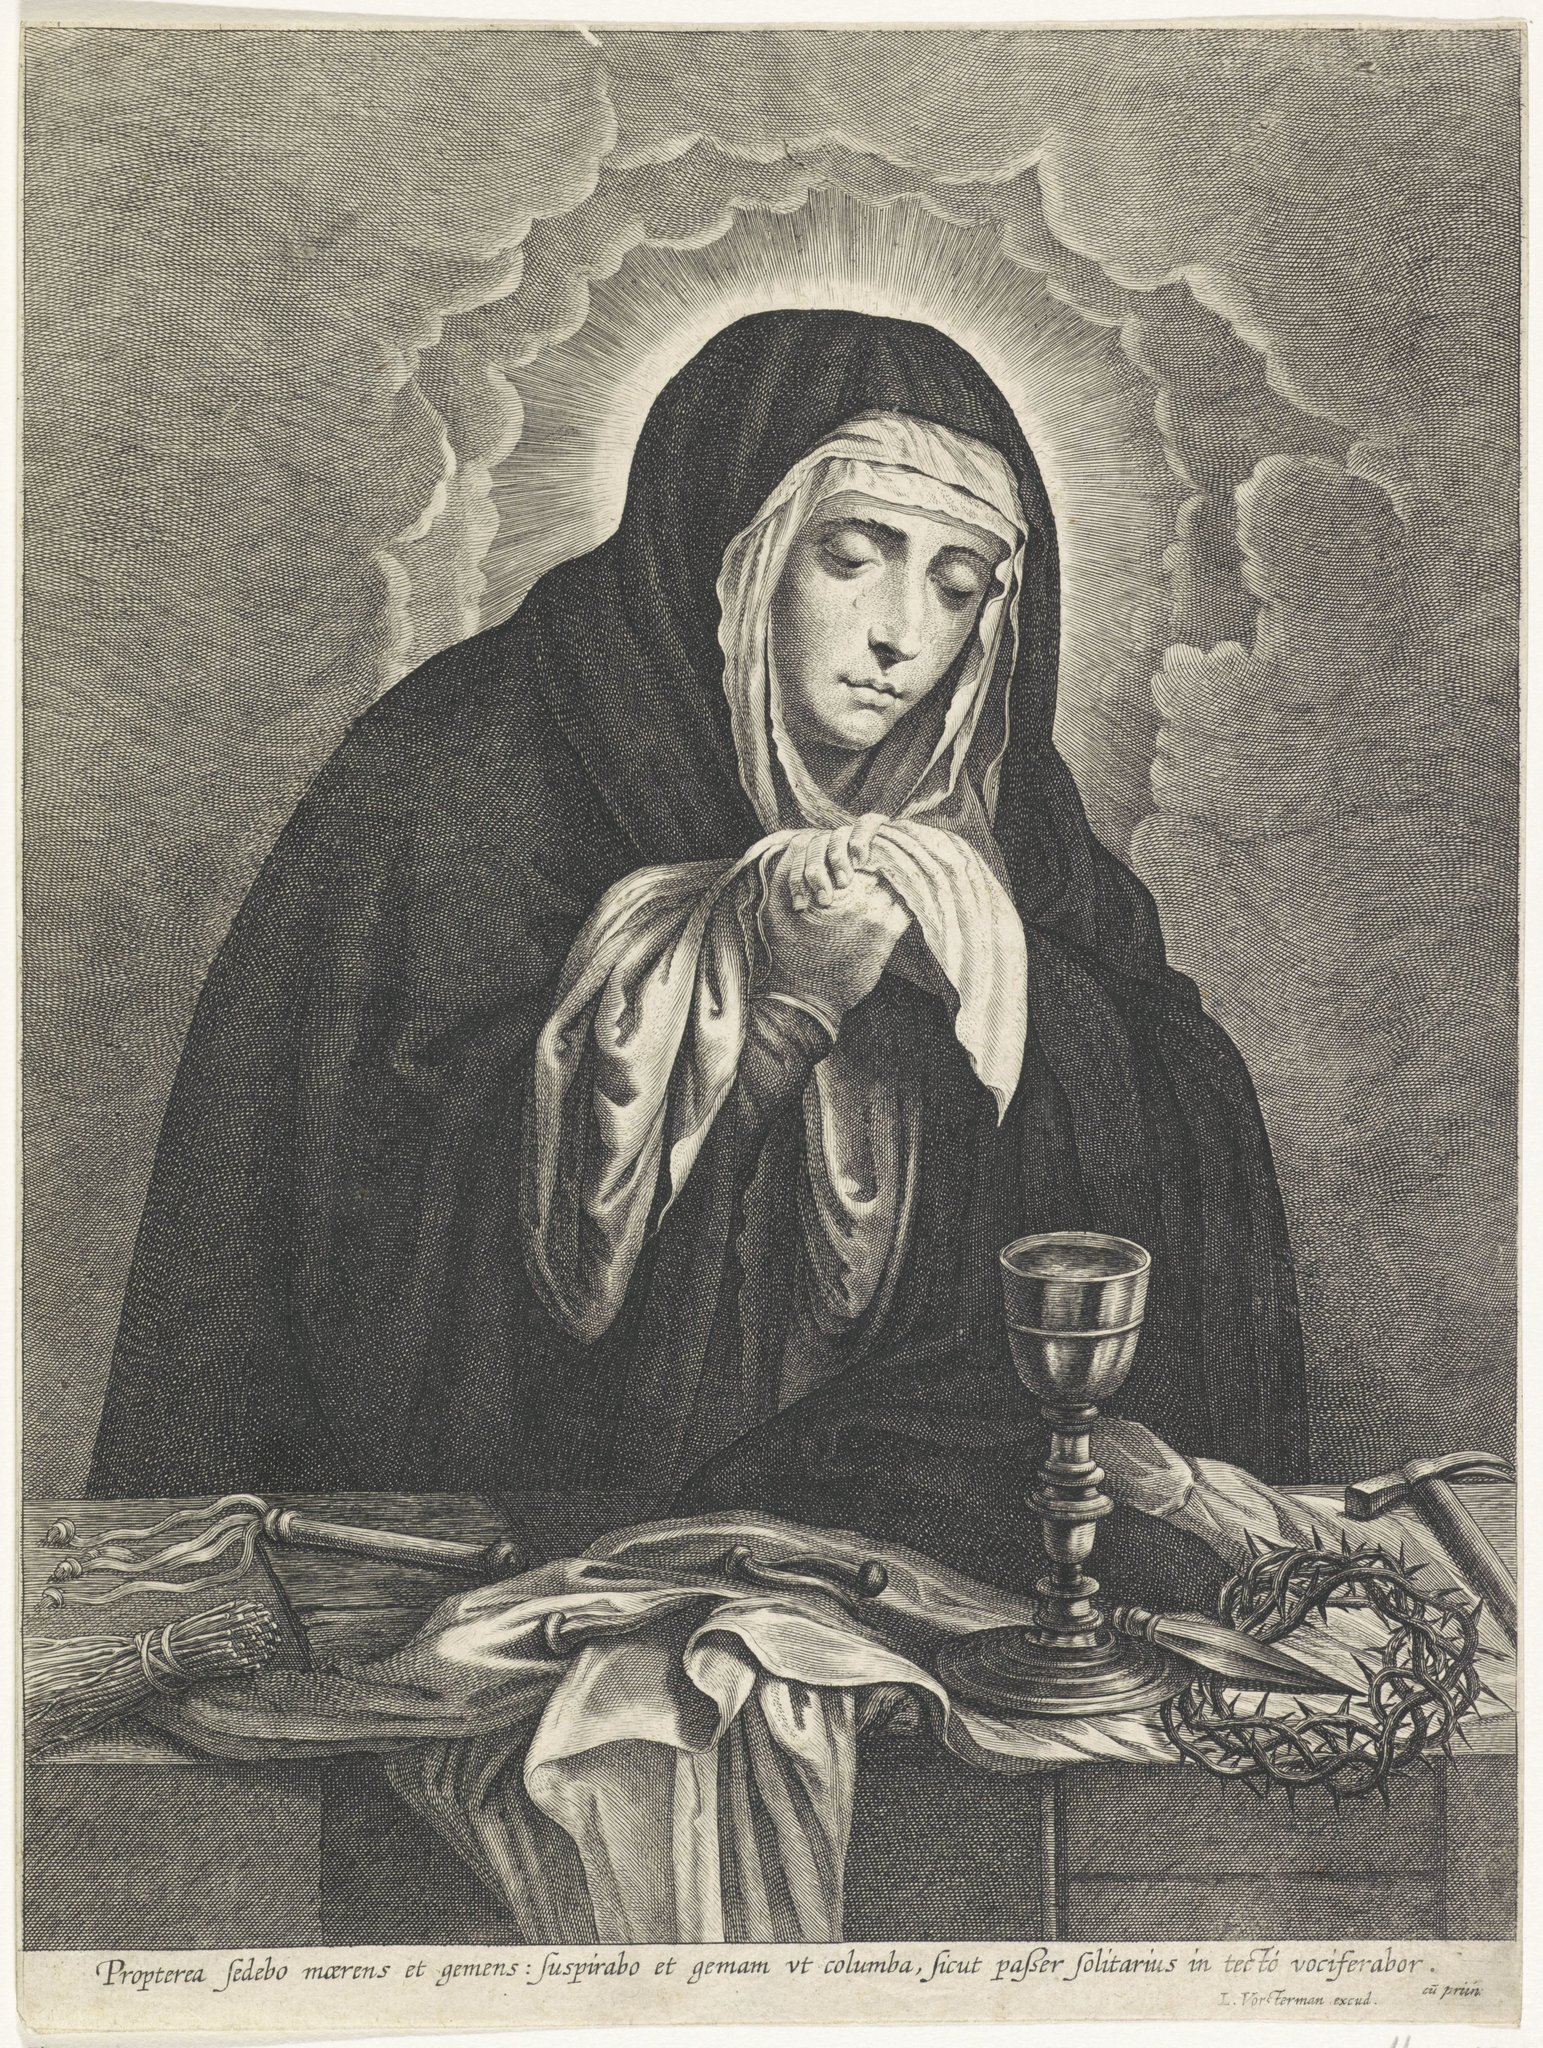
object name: print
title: Maria bij de passiewerktuigen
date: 1619-1675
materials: paper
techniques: engraving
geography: antwerp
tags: mary with the instruments of the passion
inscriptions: collector's mark: Lugt 240